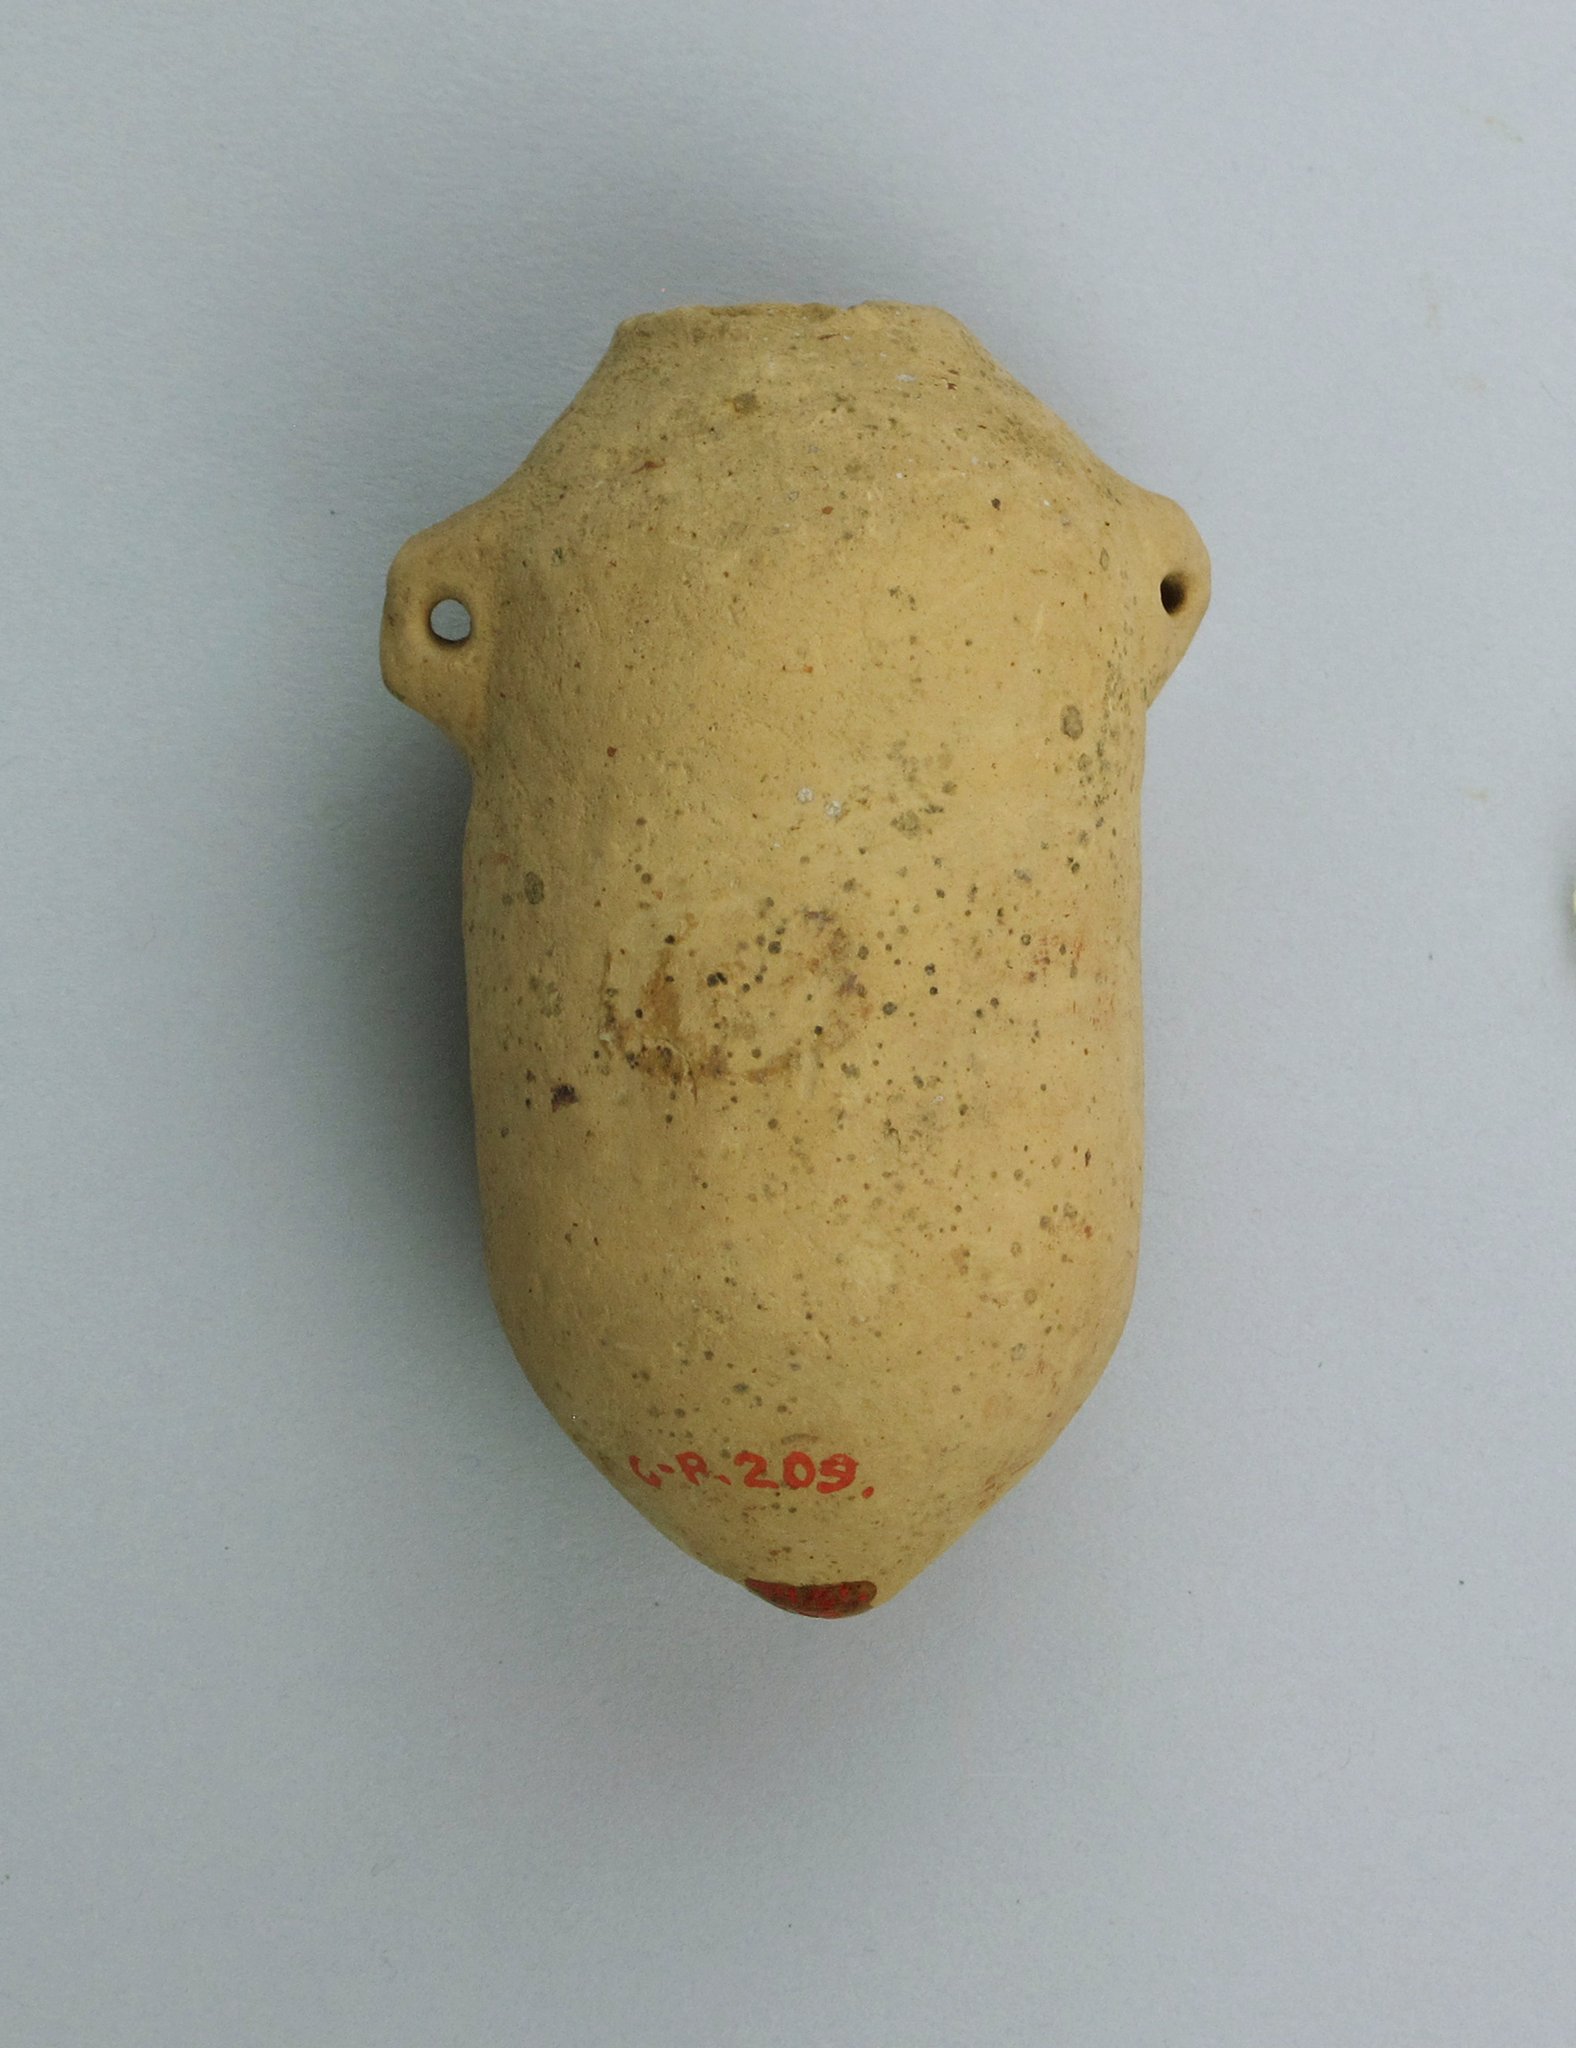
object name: vase, miniature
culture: cypriot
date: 3900 BCE-100 CE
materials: terracotta